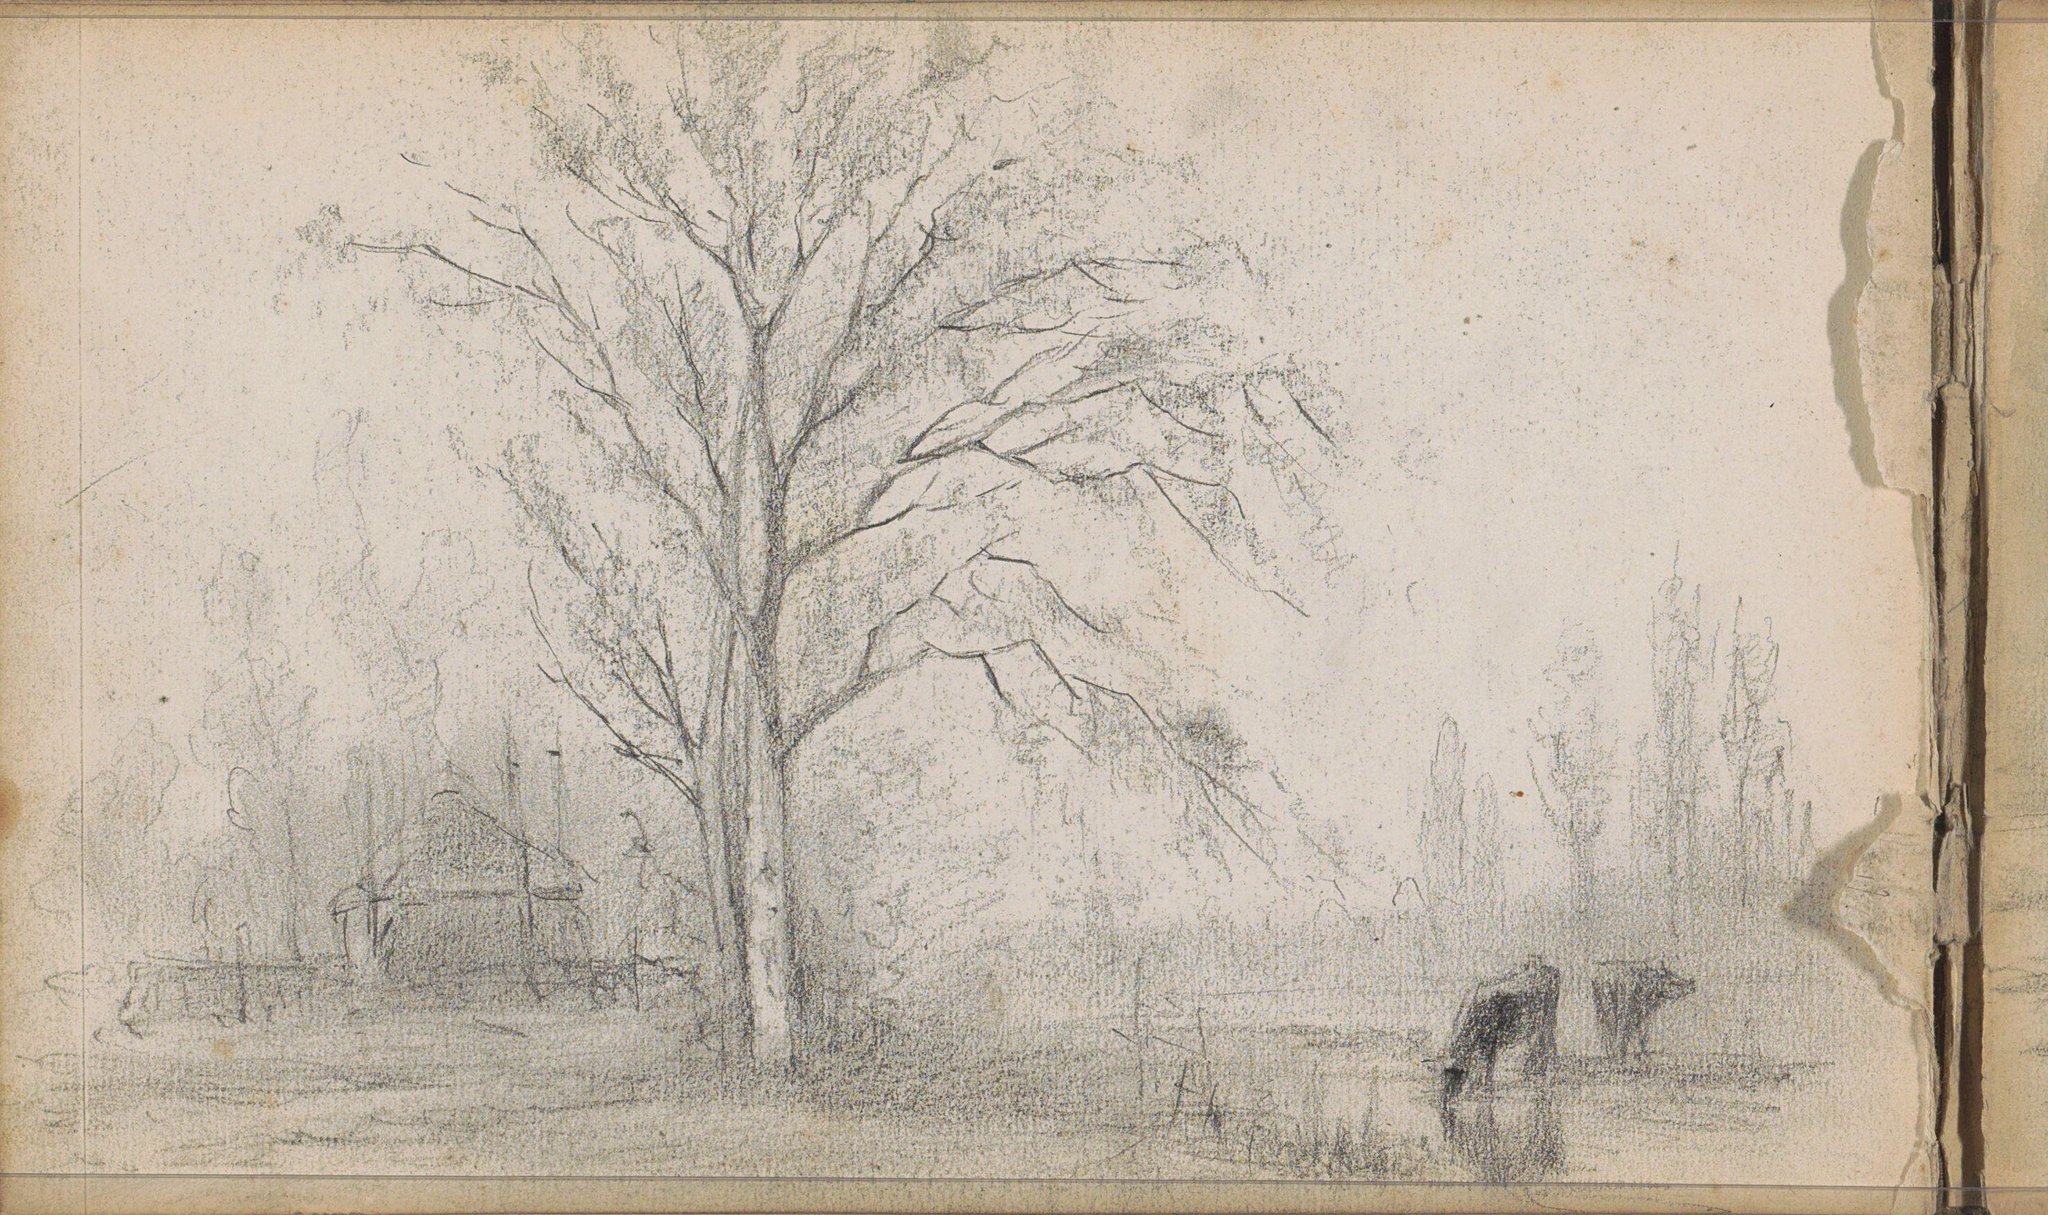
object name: sketchbook leaf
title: Koeien bij een waterplaats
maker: willem cornelis rip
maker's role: draughtsman, painter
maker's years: 1856-1922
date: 1876-1877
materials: paper, pencil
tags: cow, watering-place, spa, farm (building)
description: Op de achtergrond een boerderij. Blad 40 verso uit een schetsboek met 41 bladen.